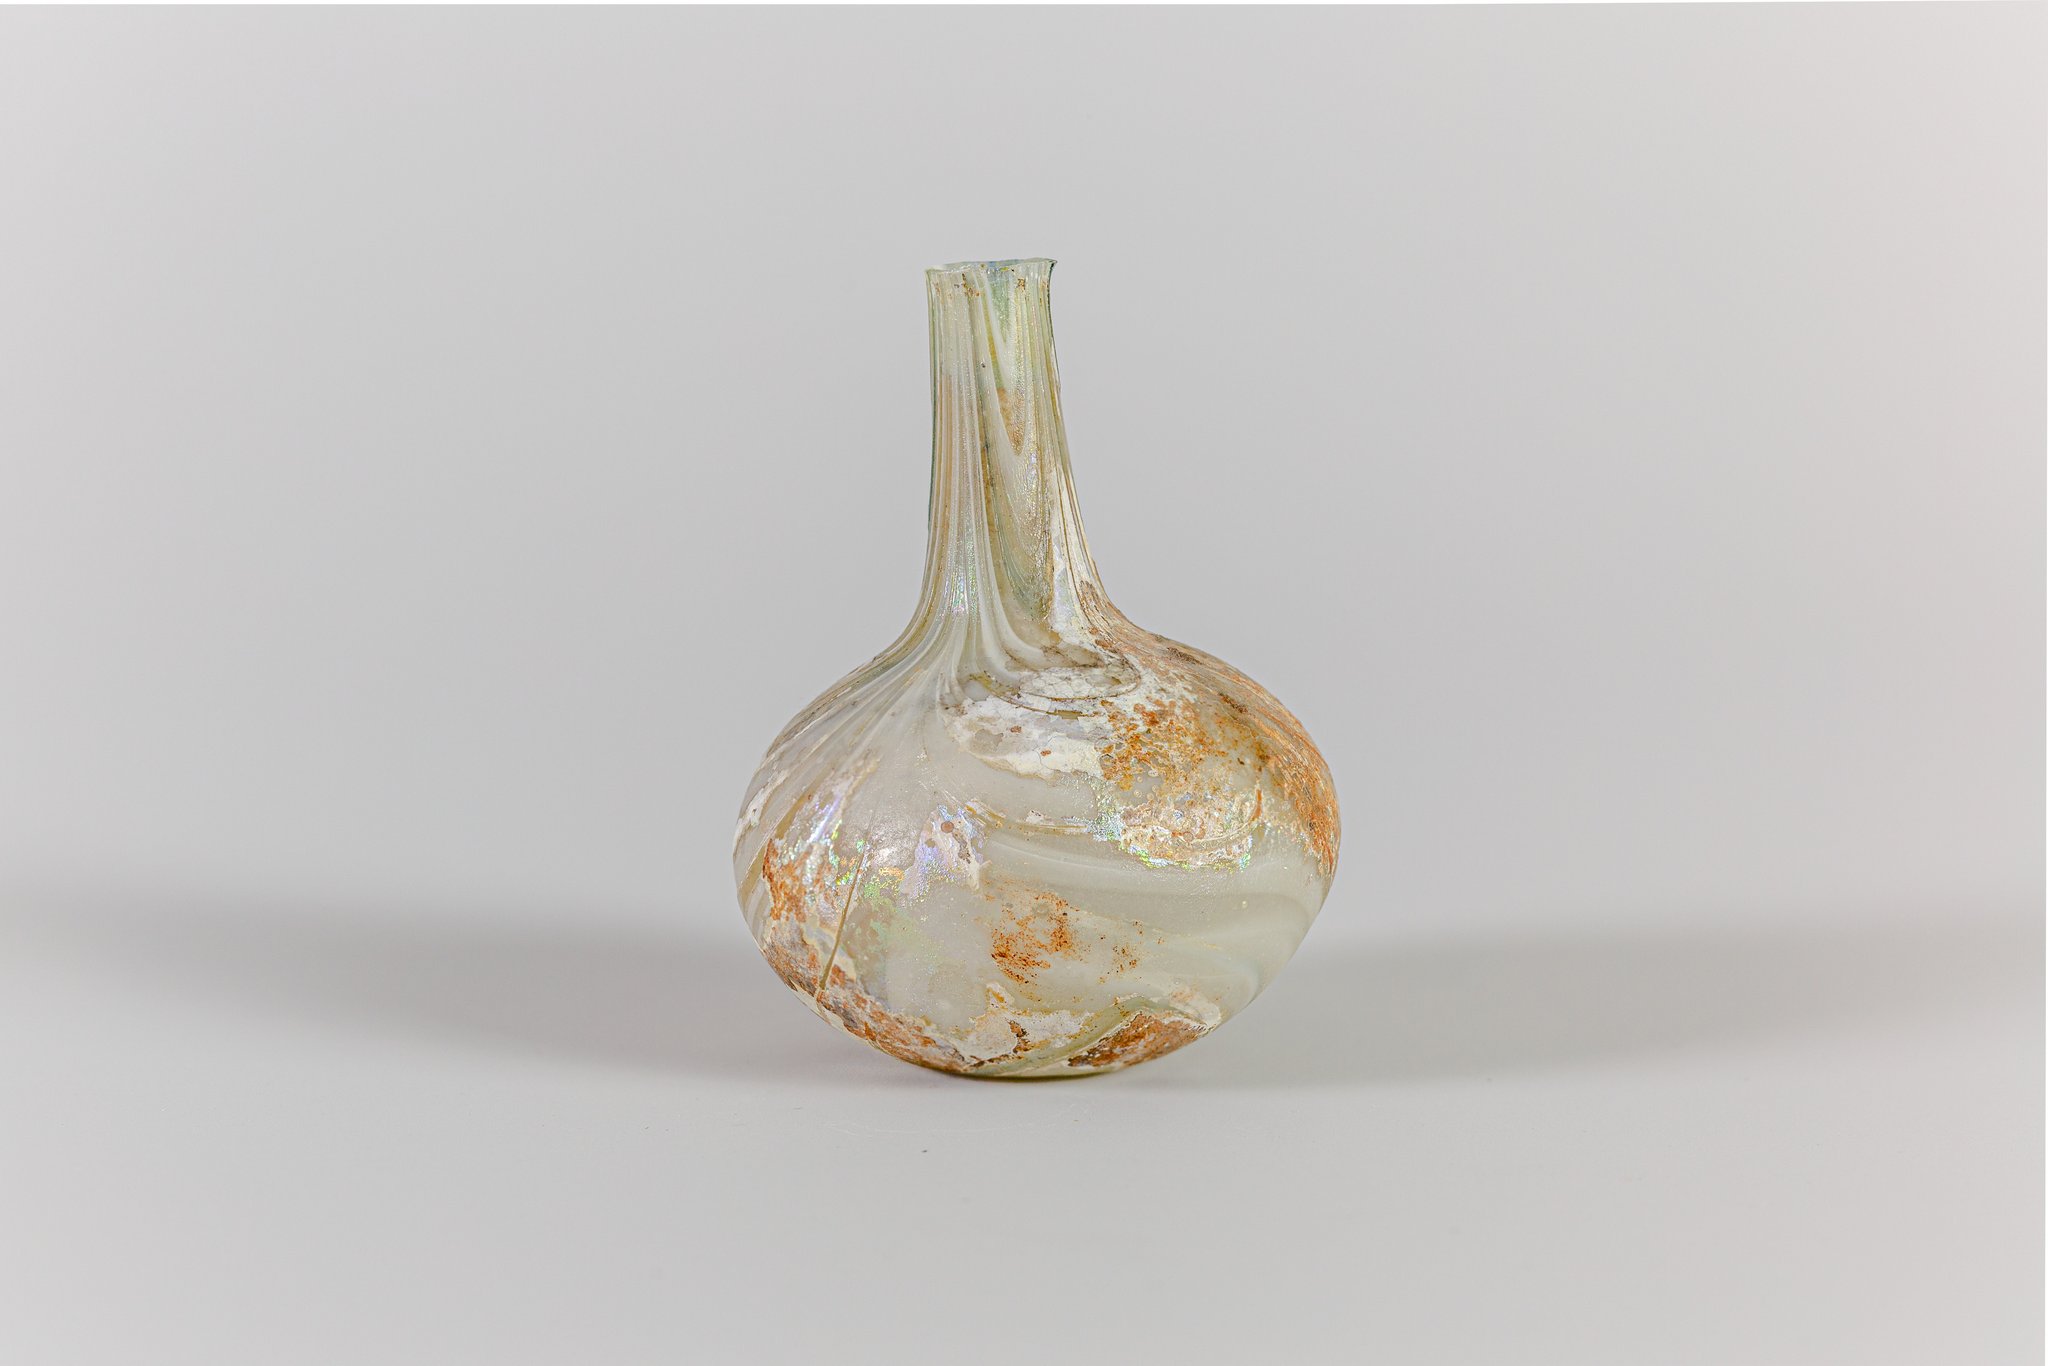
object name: perfume bottle, mosaic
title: Glass mosaic perfume bottle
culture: roman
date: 1-100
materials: glass